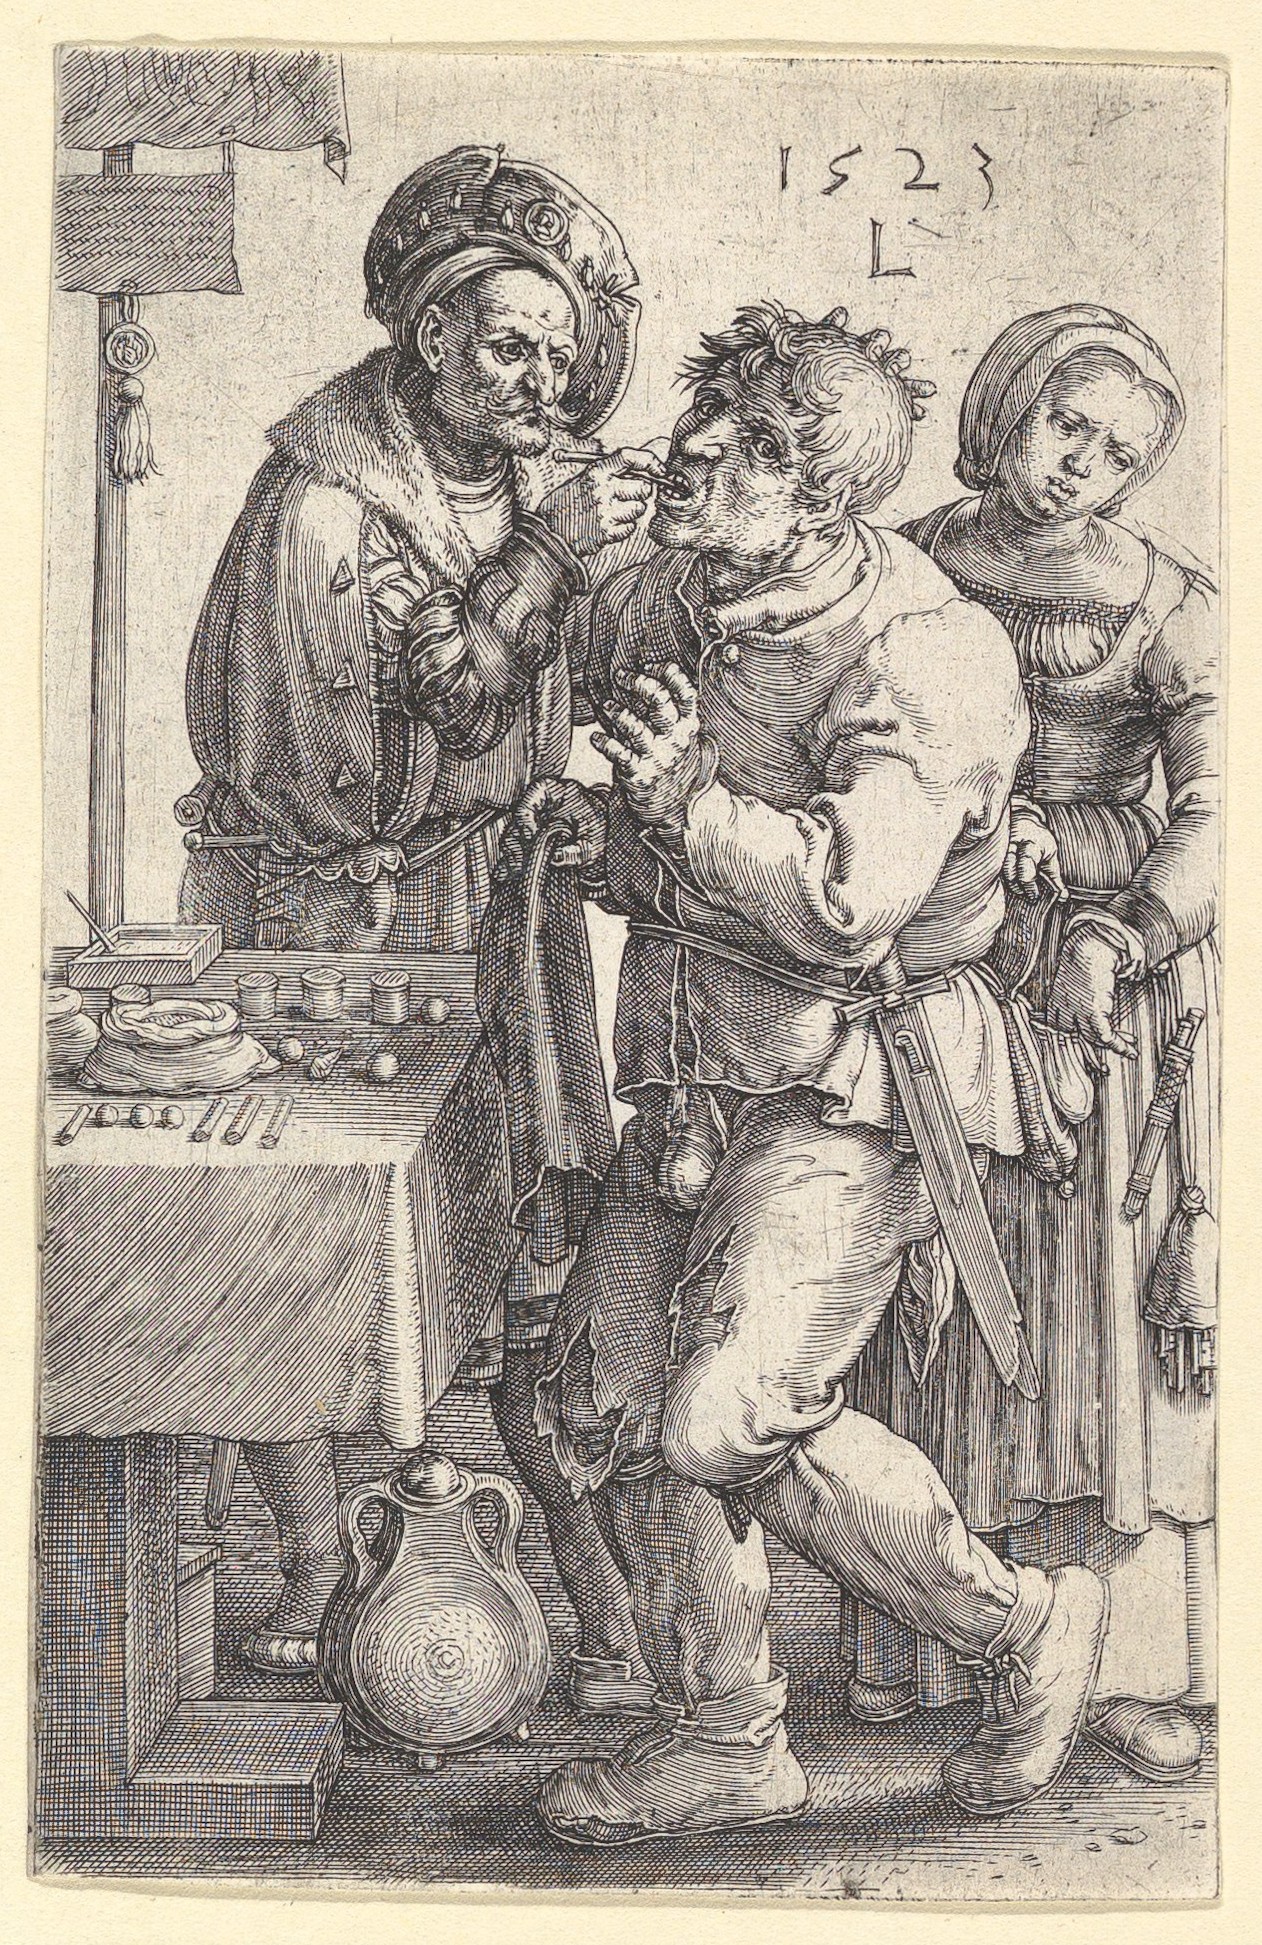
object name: print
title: The Dentist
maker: lucas van leyden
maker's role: artist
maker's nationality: netherlandish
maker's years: 1494-1533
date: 1523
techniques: engraving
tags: men,women,doctors